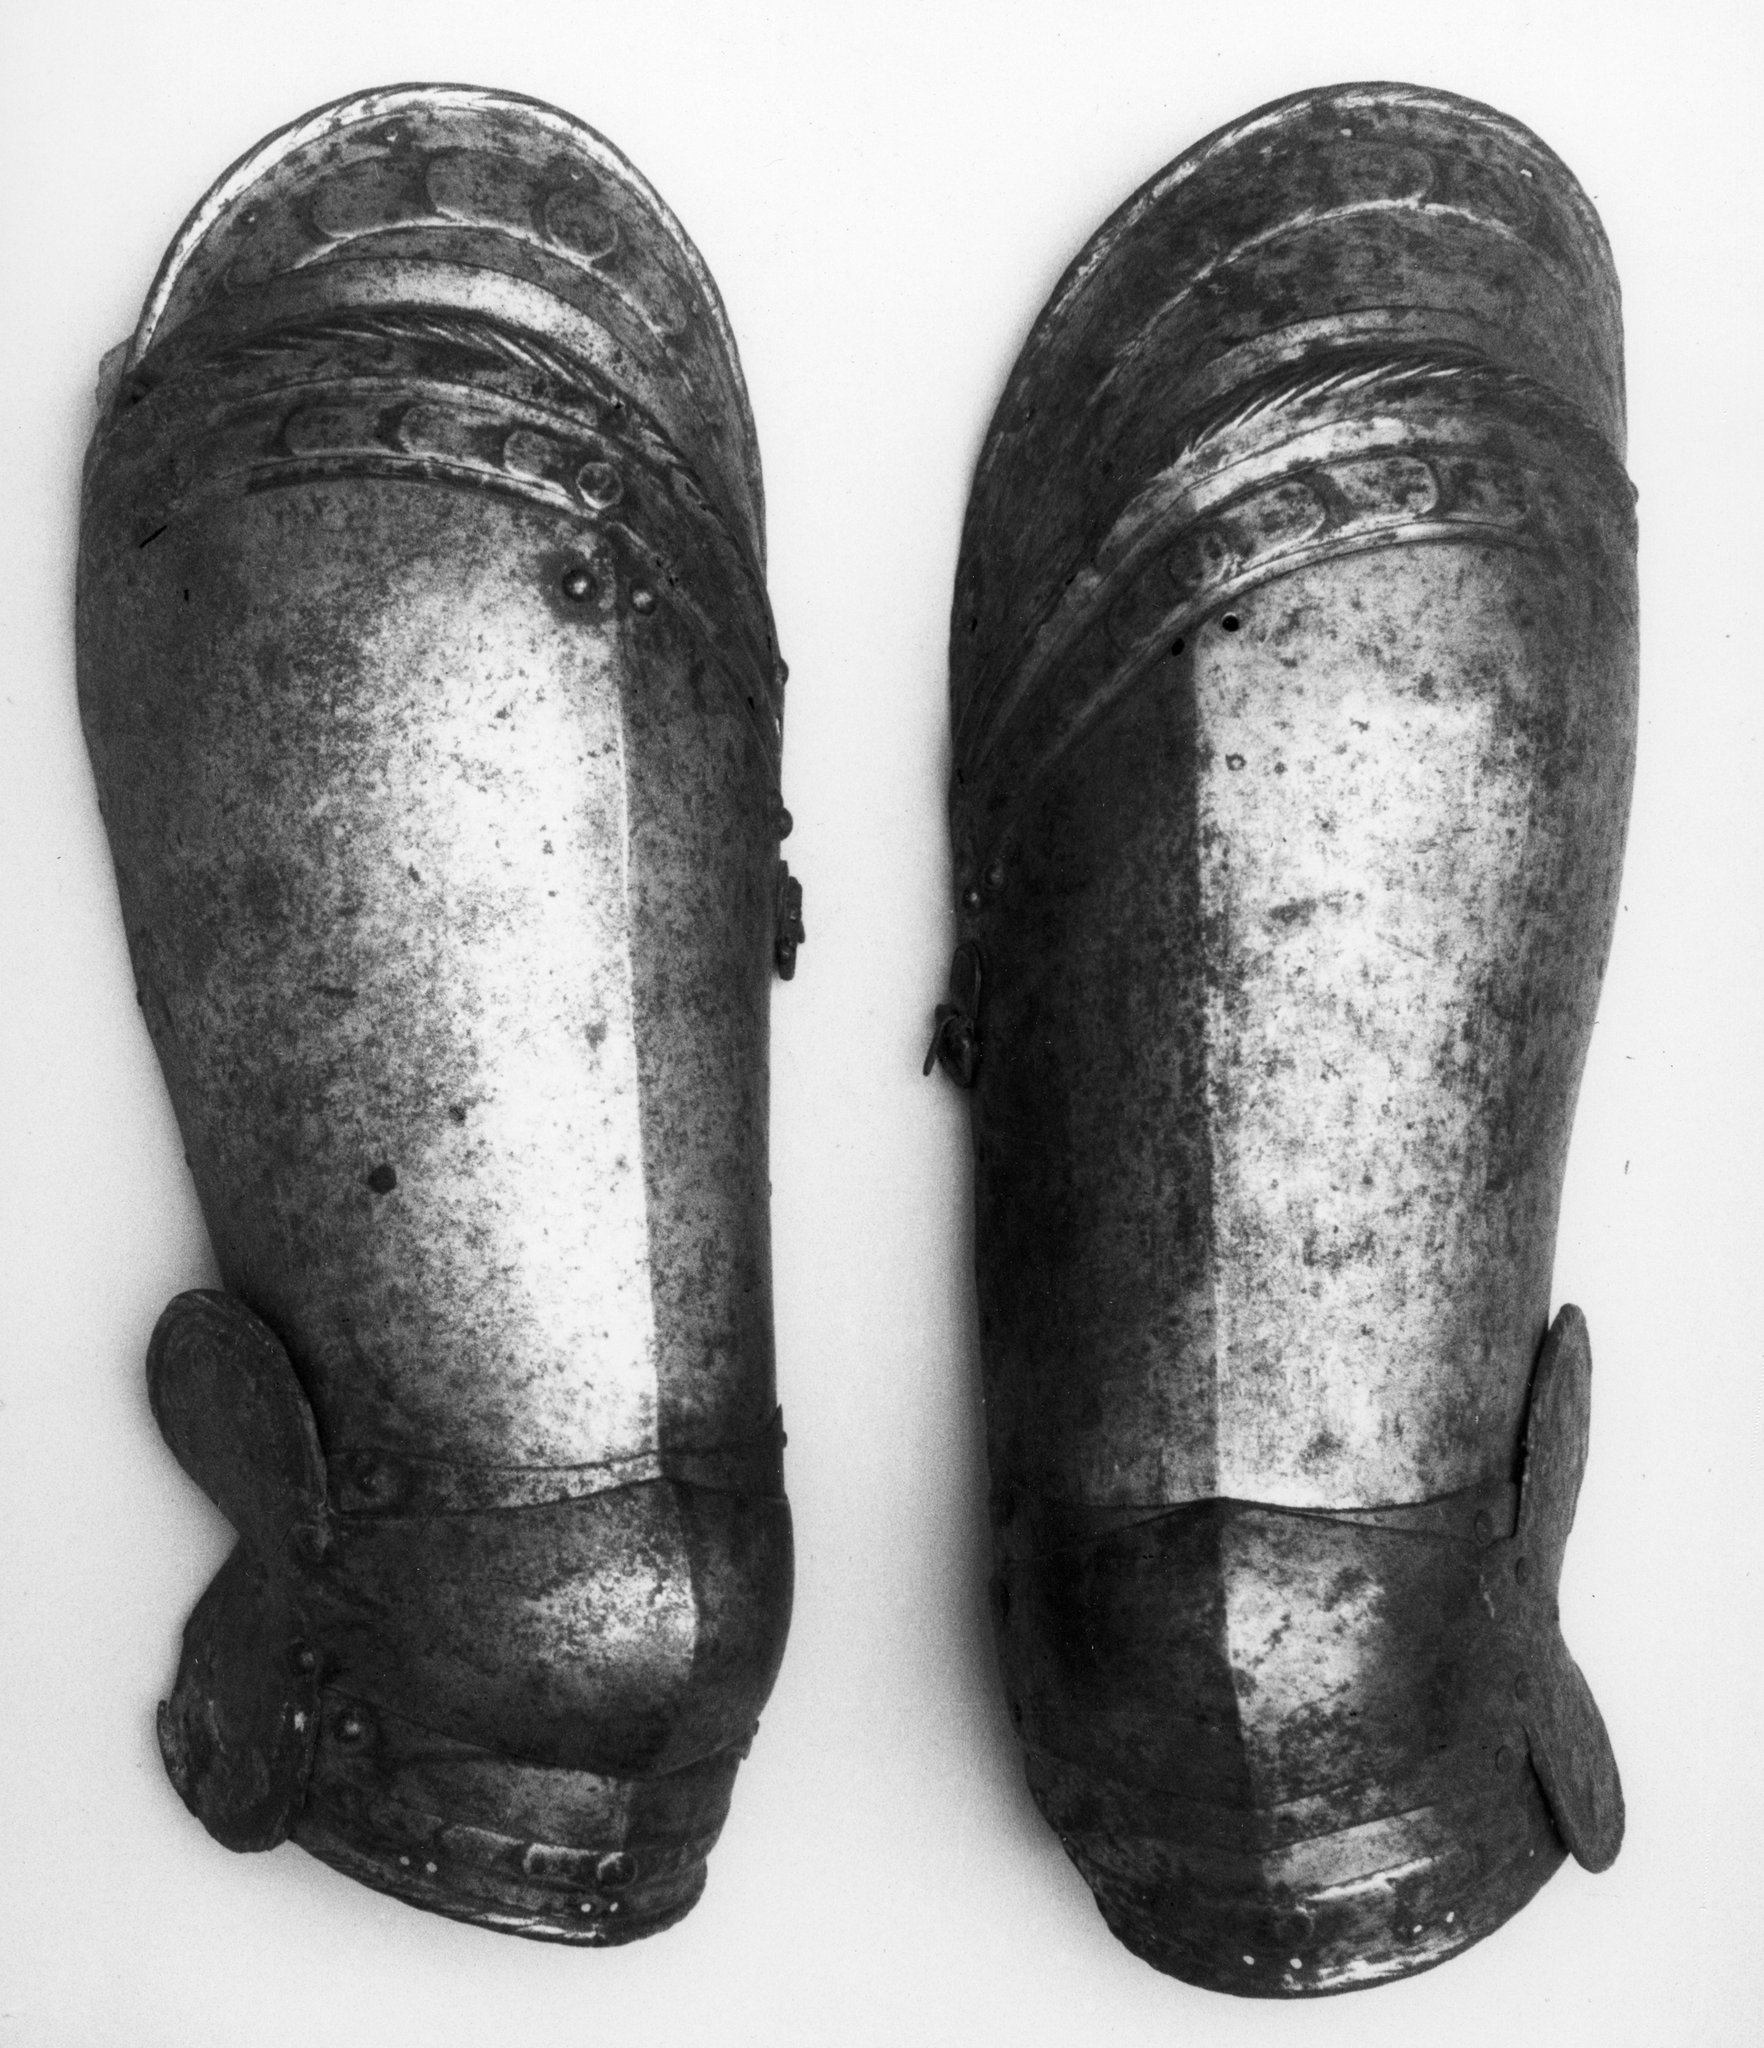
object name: pair of thigh defense cuisse with knee defense poleyns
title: Pair of Thigh Defenses (Cuisses) with Knee Defenses (Poleyns)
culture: german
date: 1501-1600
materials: steel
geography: germany